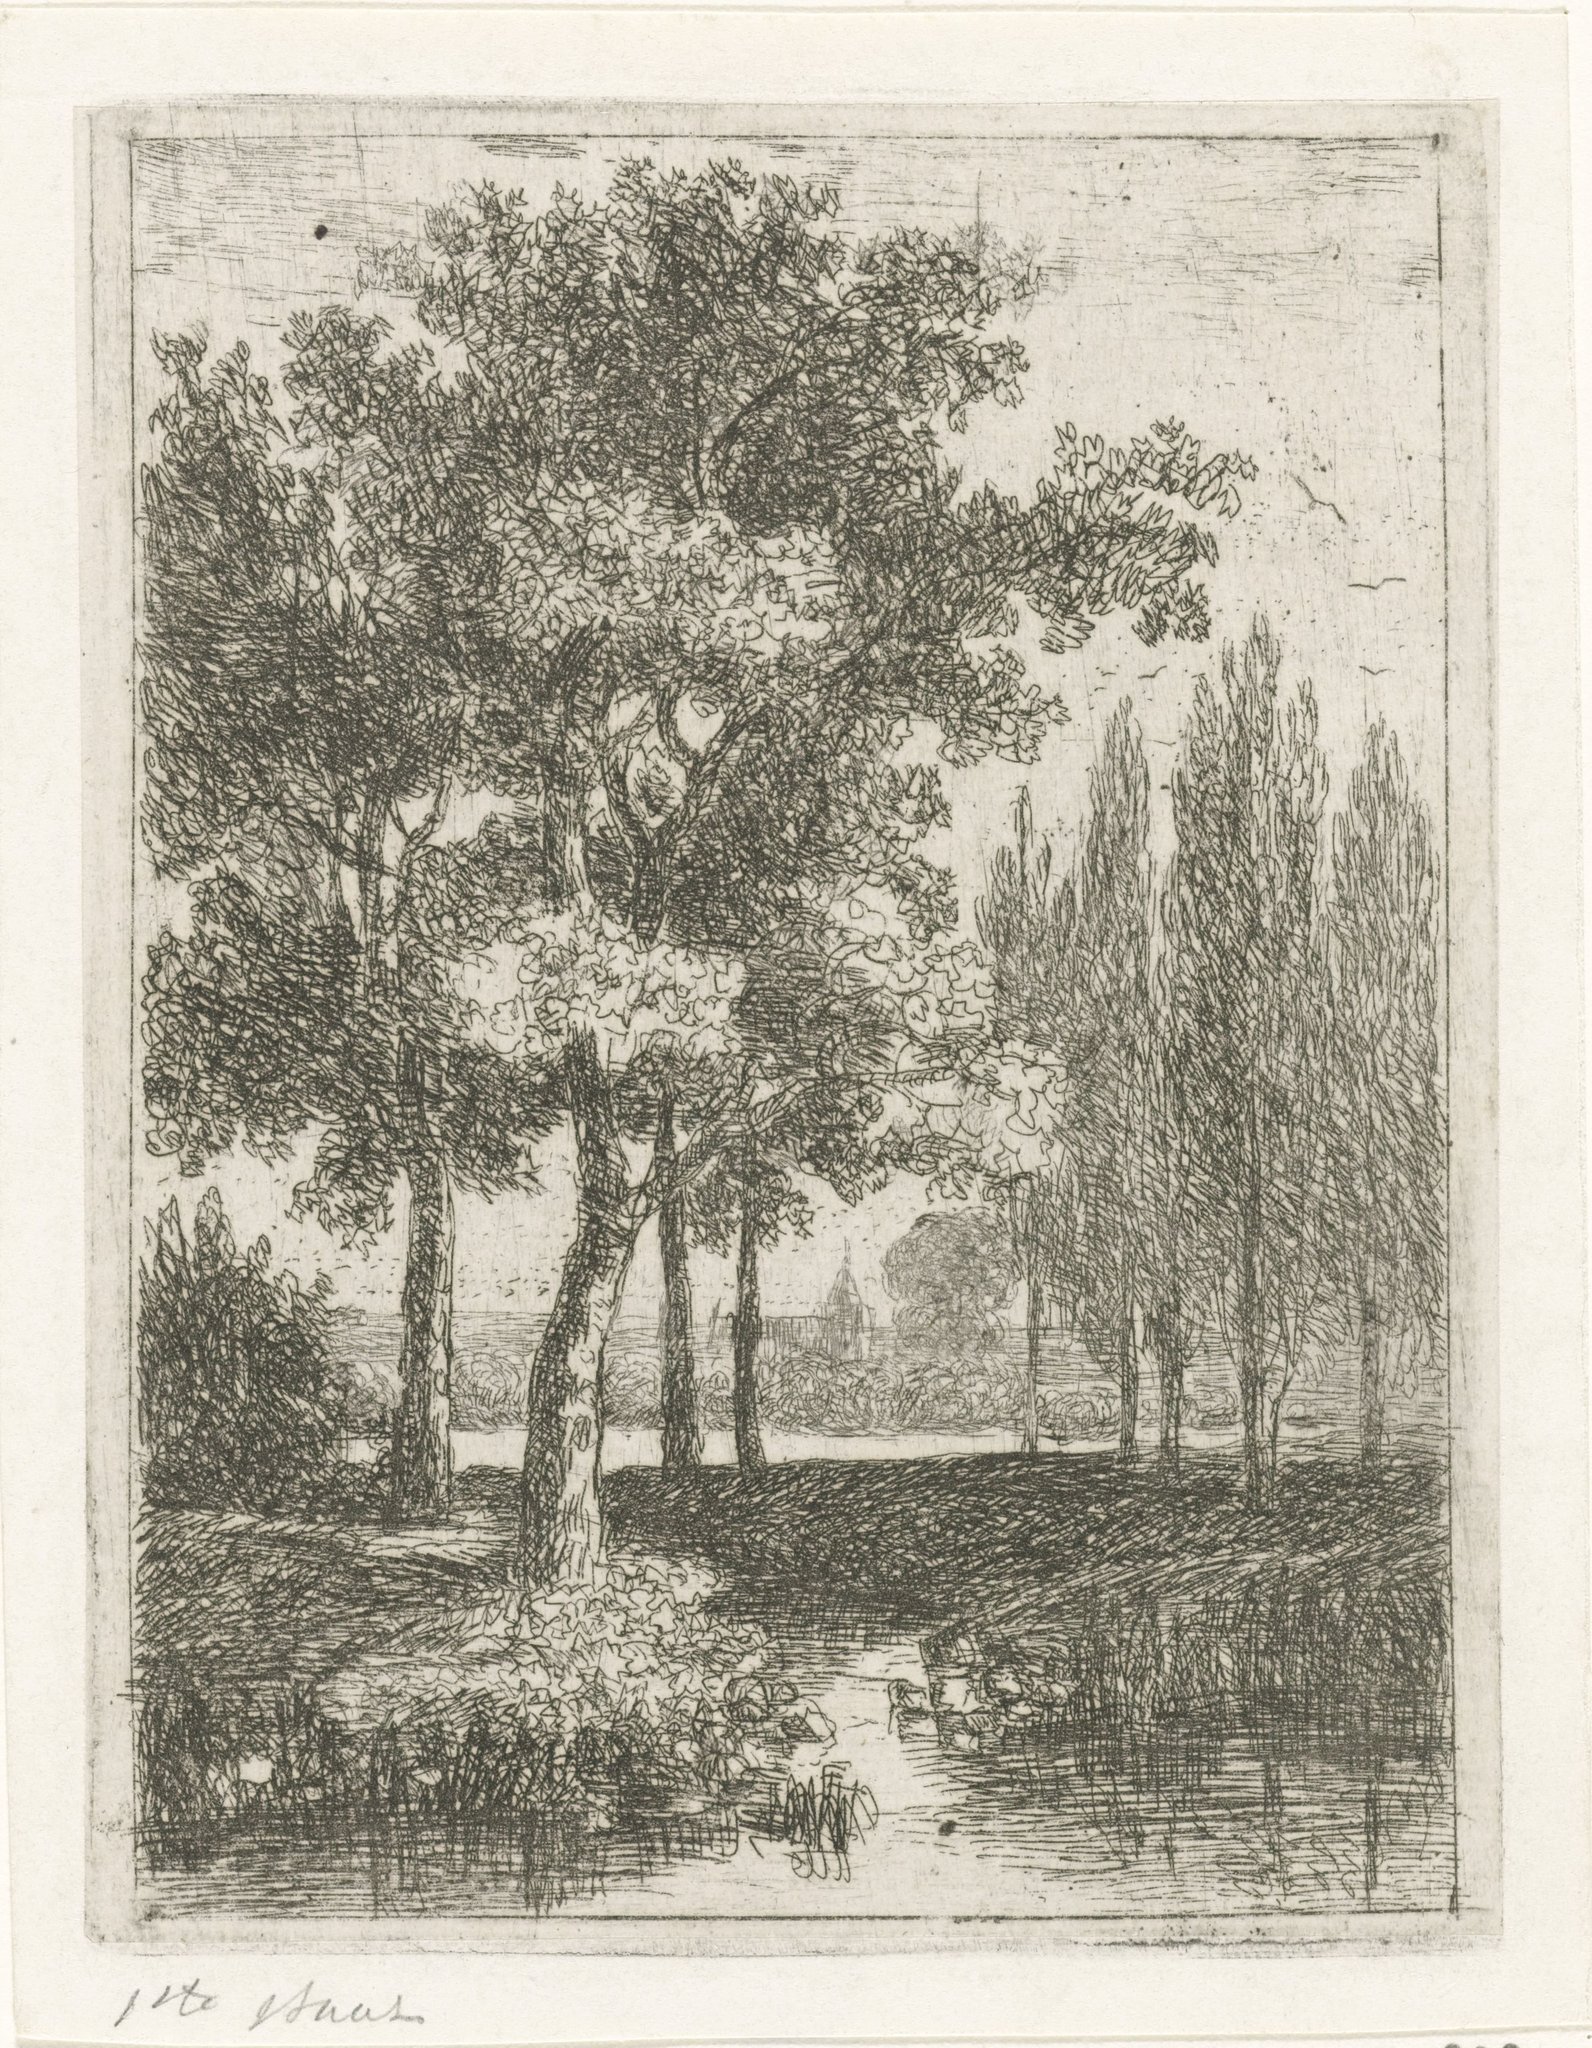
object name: print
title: Landschap met een beekje en populieren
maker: hermanus jan hendrik van rijkelijkhuysen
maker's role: painter, print maker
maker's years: 1813-1883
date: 1823-1883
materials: paper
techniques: etching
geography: utrecht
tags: trees: poplar, church (exterior), brook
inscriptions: collector's mark: Lugt 2228, inscription: ‘1 ste staat’